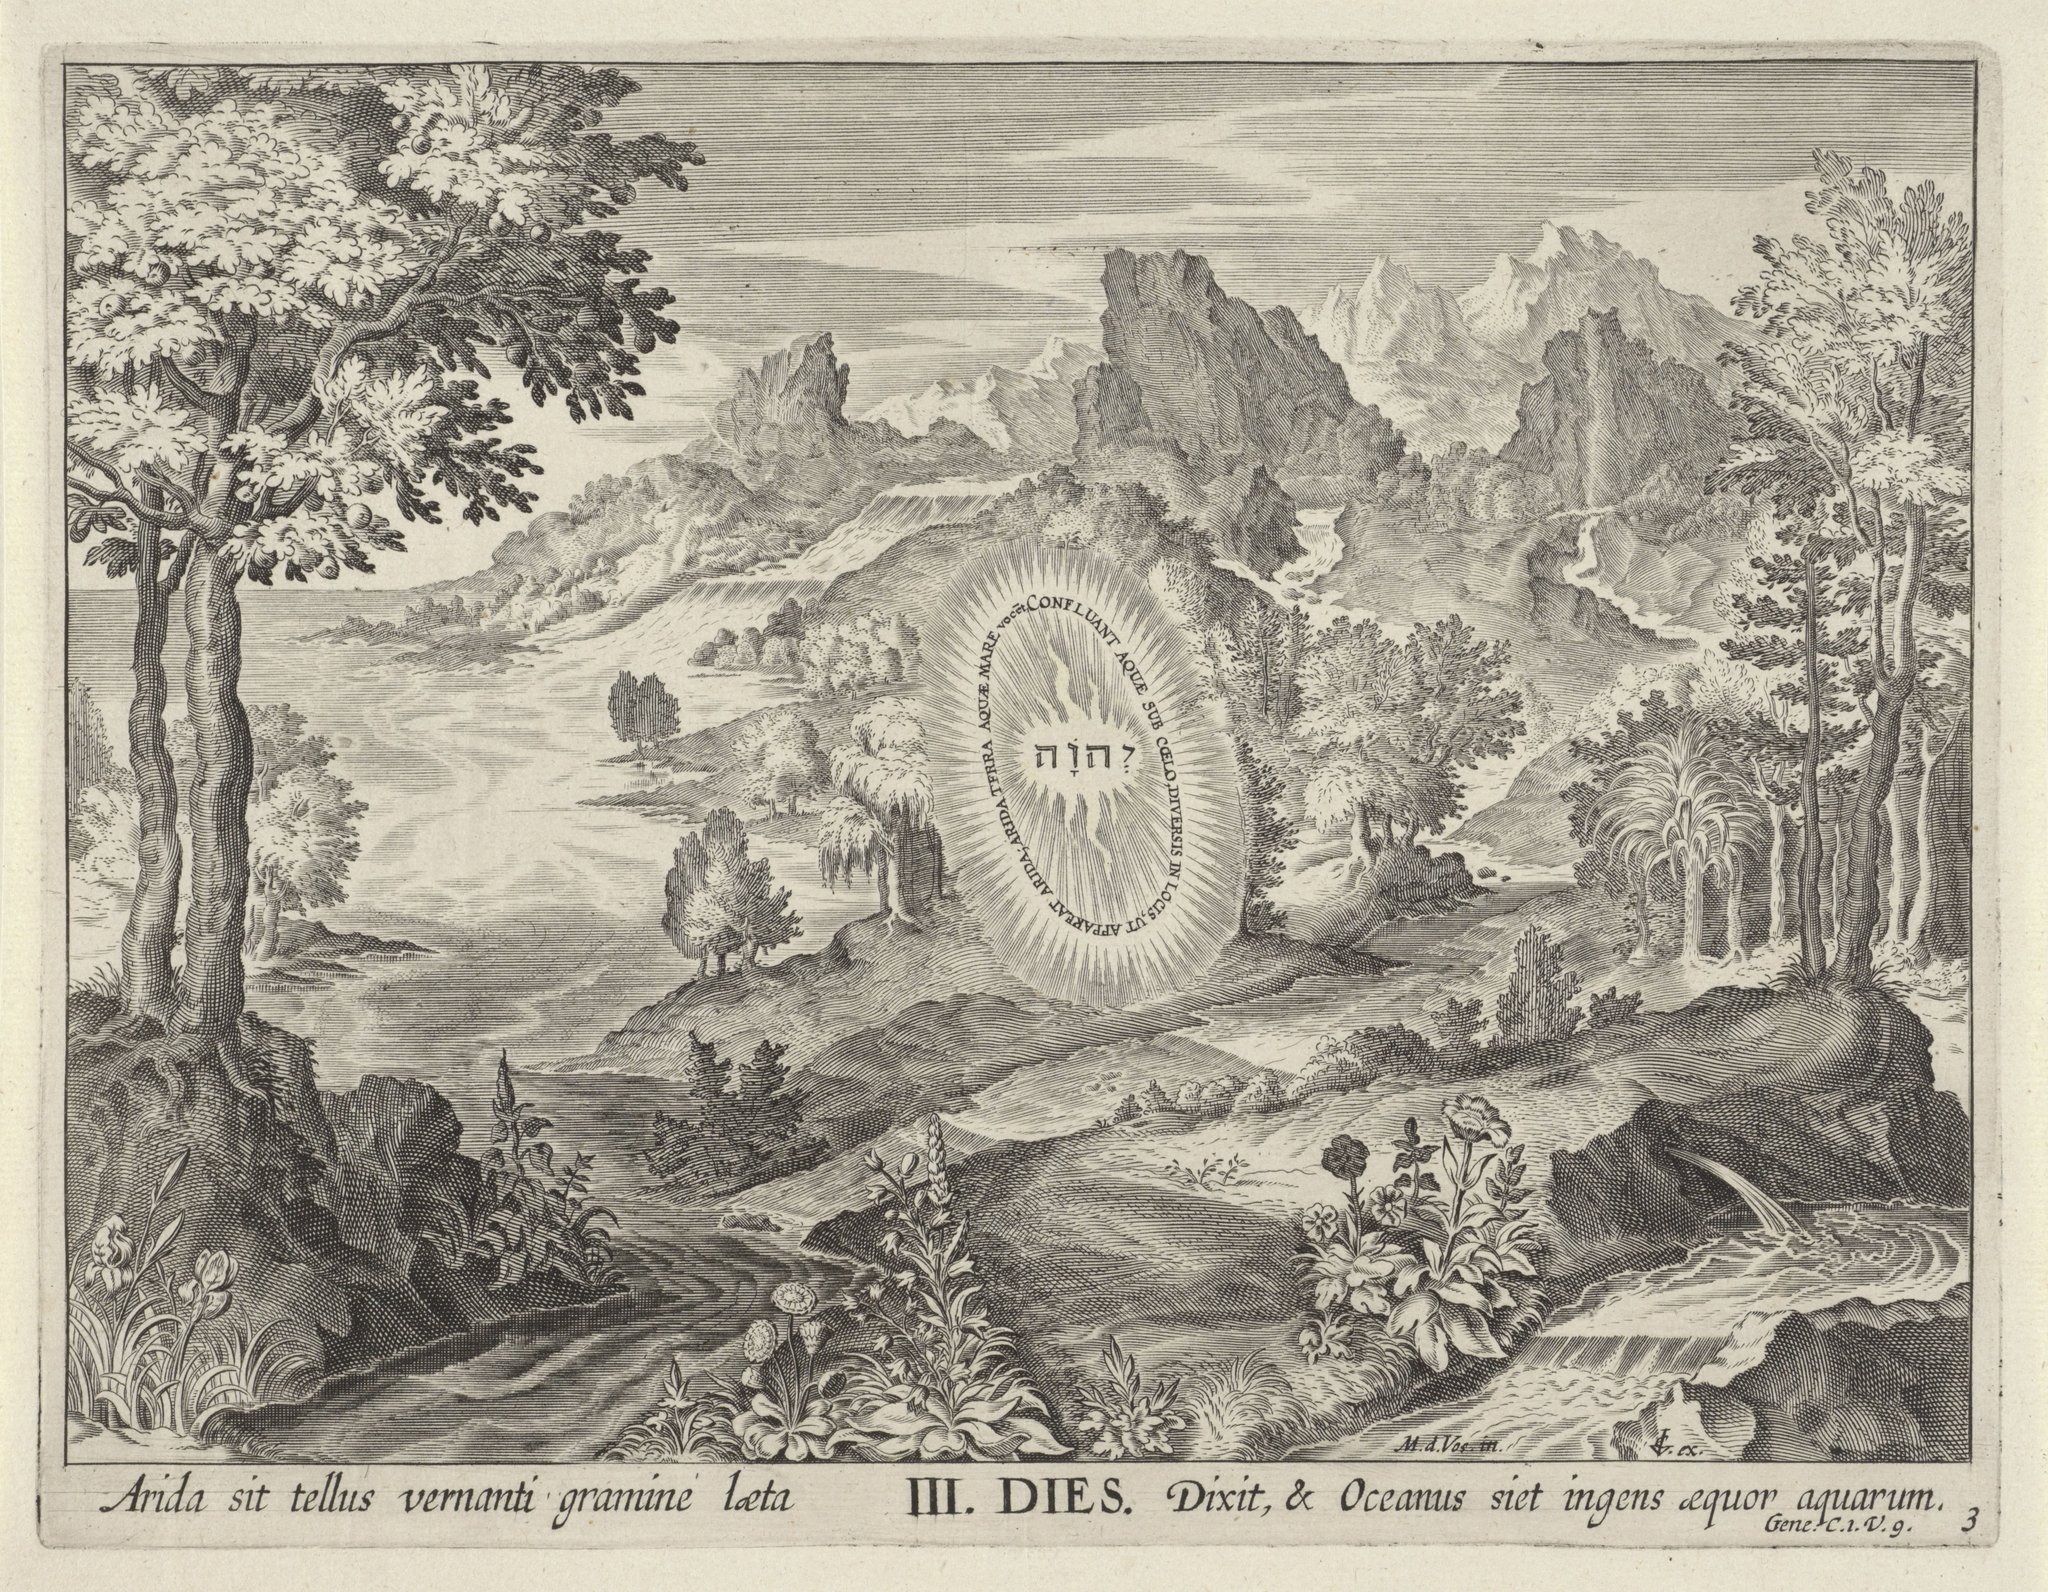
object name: print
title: Schepping van de wereld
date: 1588-1600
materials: paper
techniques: engraving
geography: amsterdam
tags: gathering of the waters below the firmament; dry land appears and produces all kinds of plants, tetragram (in roman or hebrew script) ~ symbol of god the father, coast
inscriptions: collector's mark: Lugt 2228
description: Een kustlandschap met centraal God de Vader in de vorm van een tetragram. Op de derde dag van de schepping schiep God de aarde, de zee en de planten. De prent heeft een Latijns onderschrift.